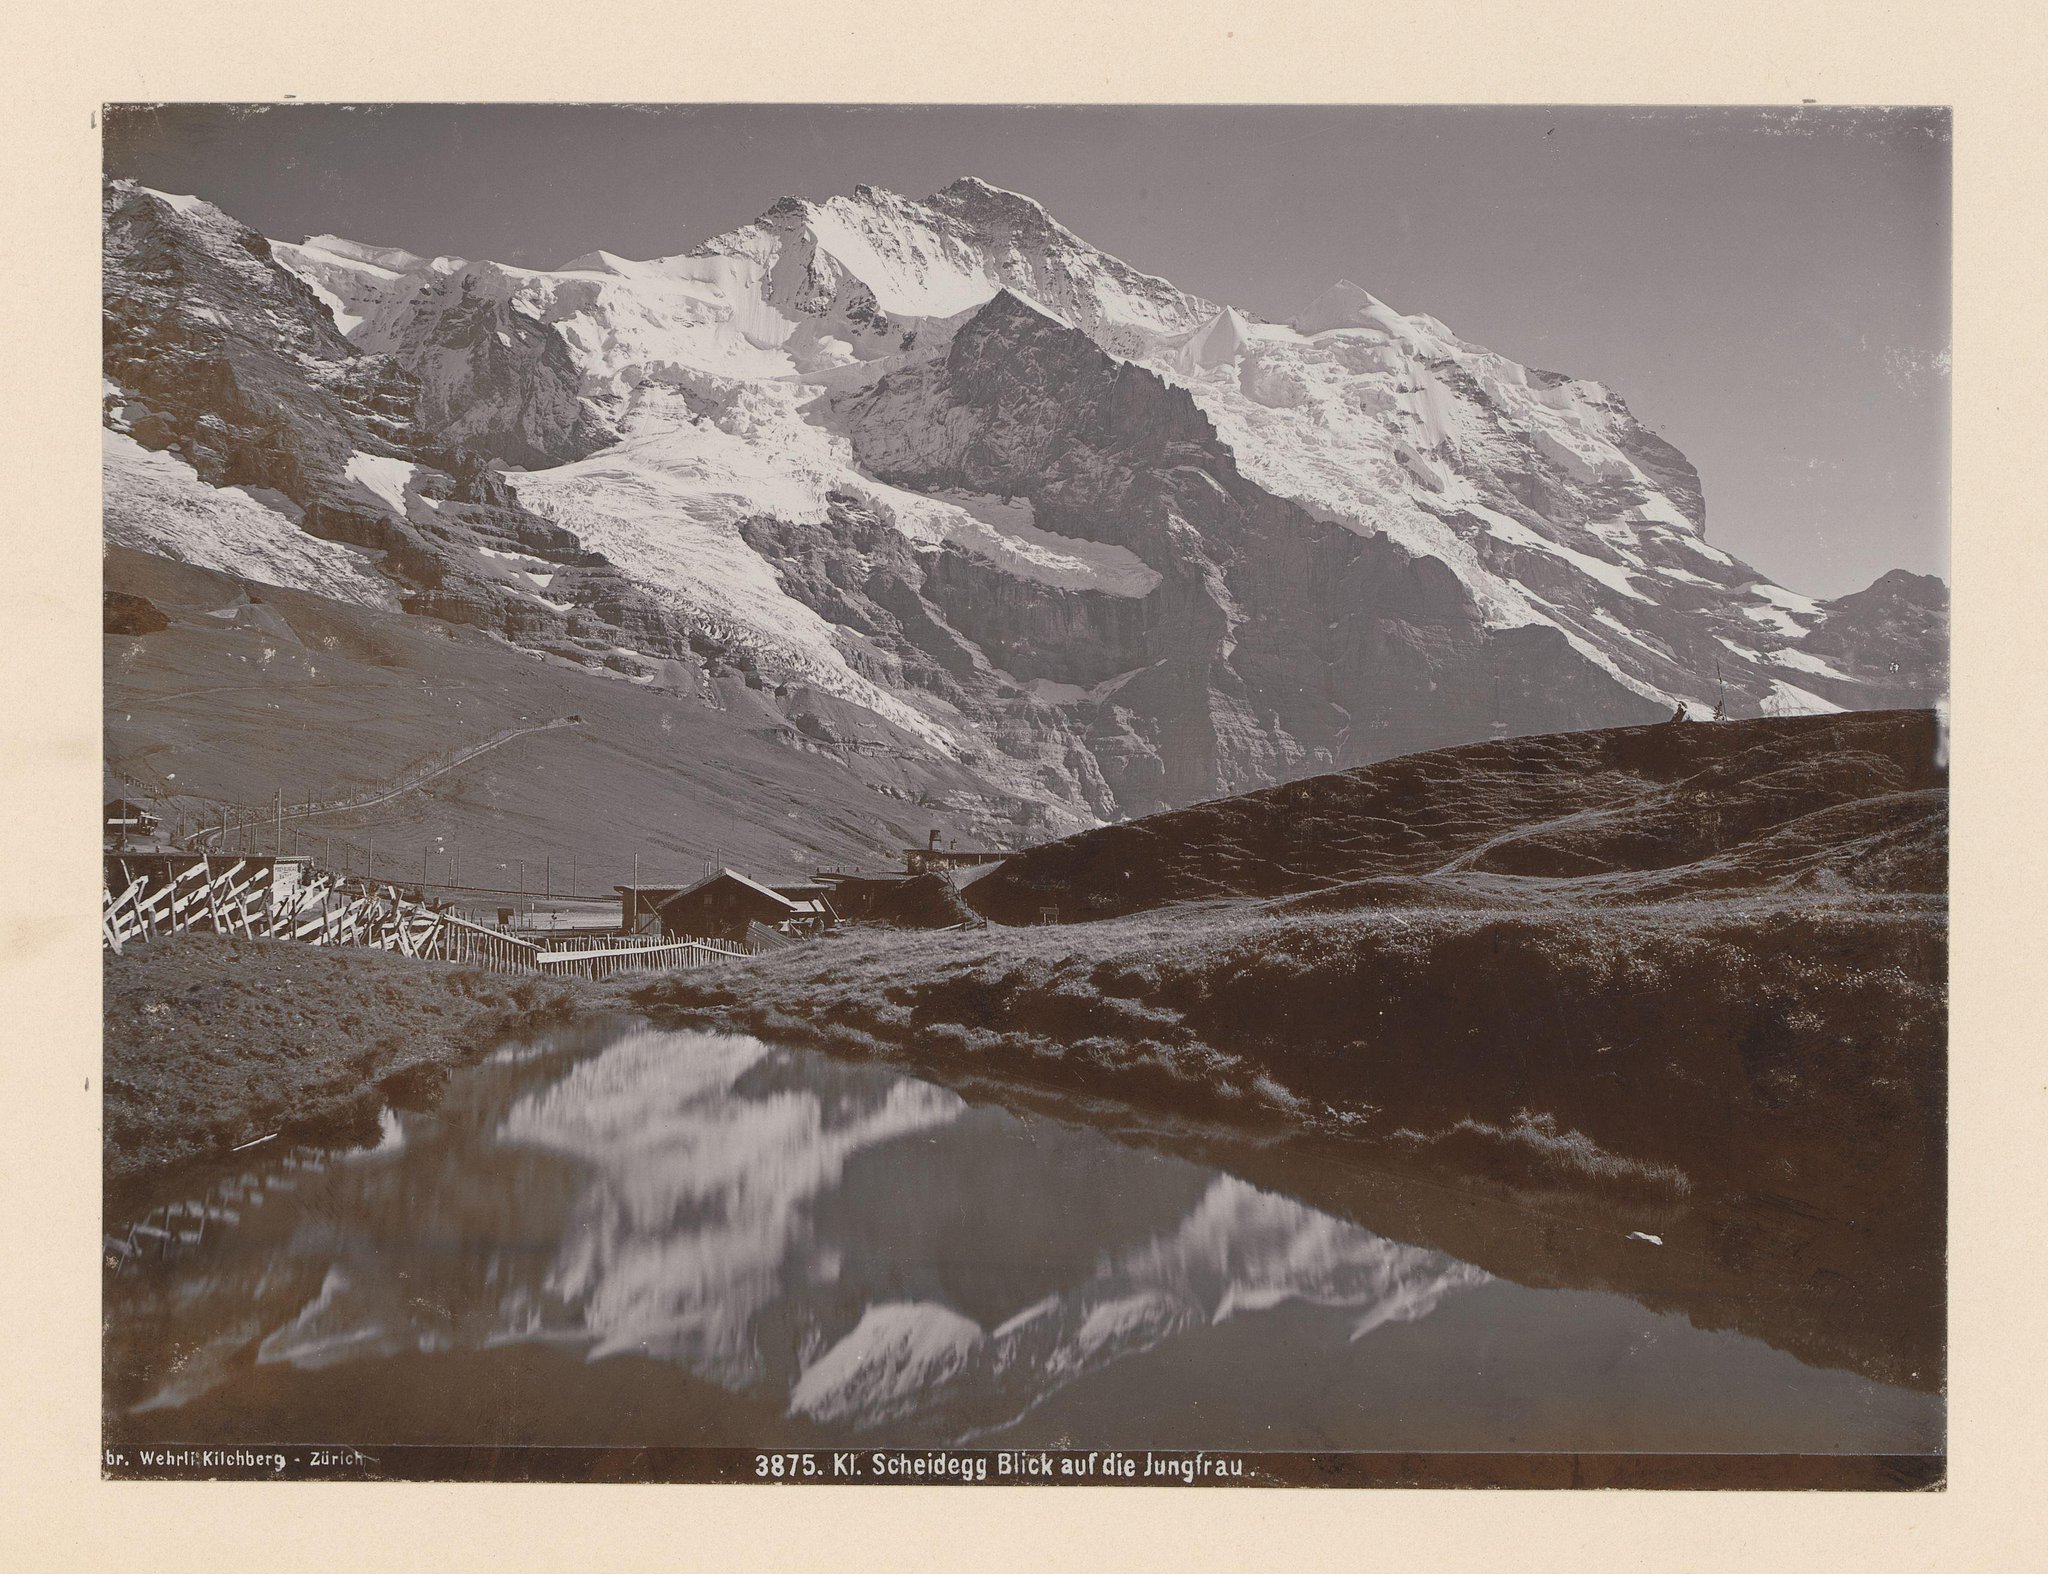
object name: photograph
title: Jungfrau, gezien vanaf de Kleine Scheidegg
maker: Anonymous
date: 1912-1920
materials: paper, cardboard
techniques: collodion silver print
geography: kilchberg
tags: mountain-top, peak, lake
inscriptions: inscription: ‘[Ge]br. Wehrli Kilchberg - Zürich 3875. Kl. Scheidegg Blick auf die Jungfrau.’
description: Deze foto maakt deel uit van een omslag.